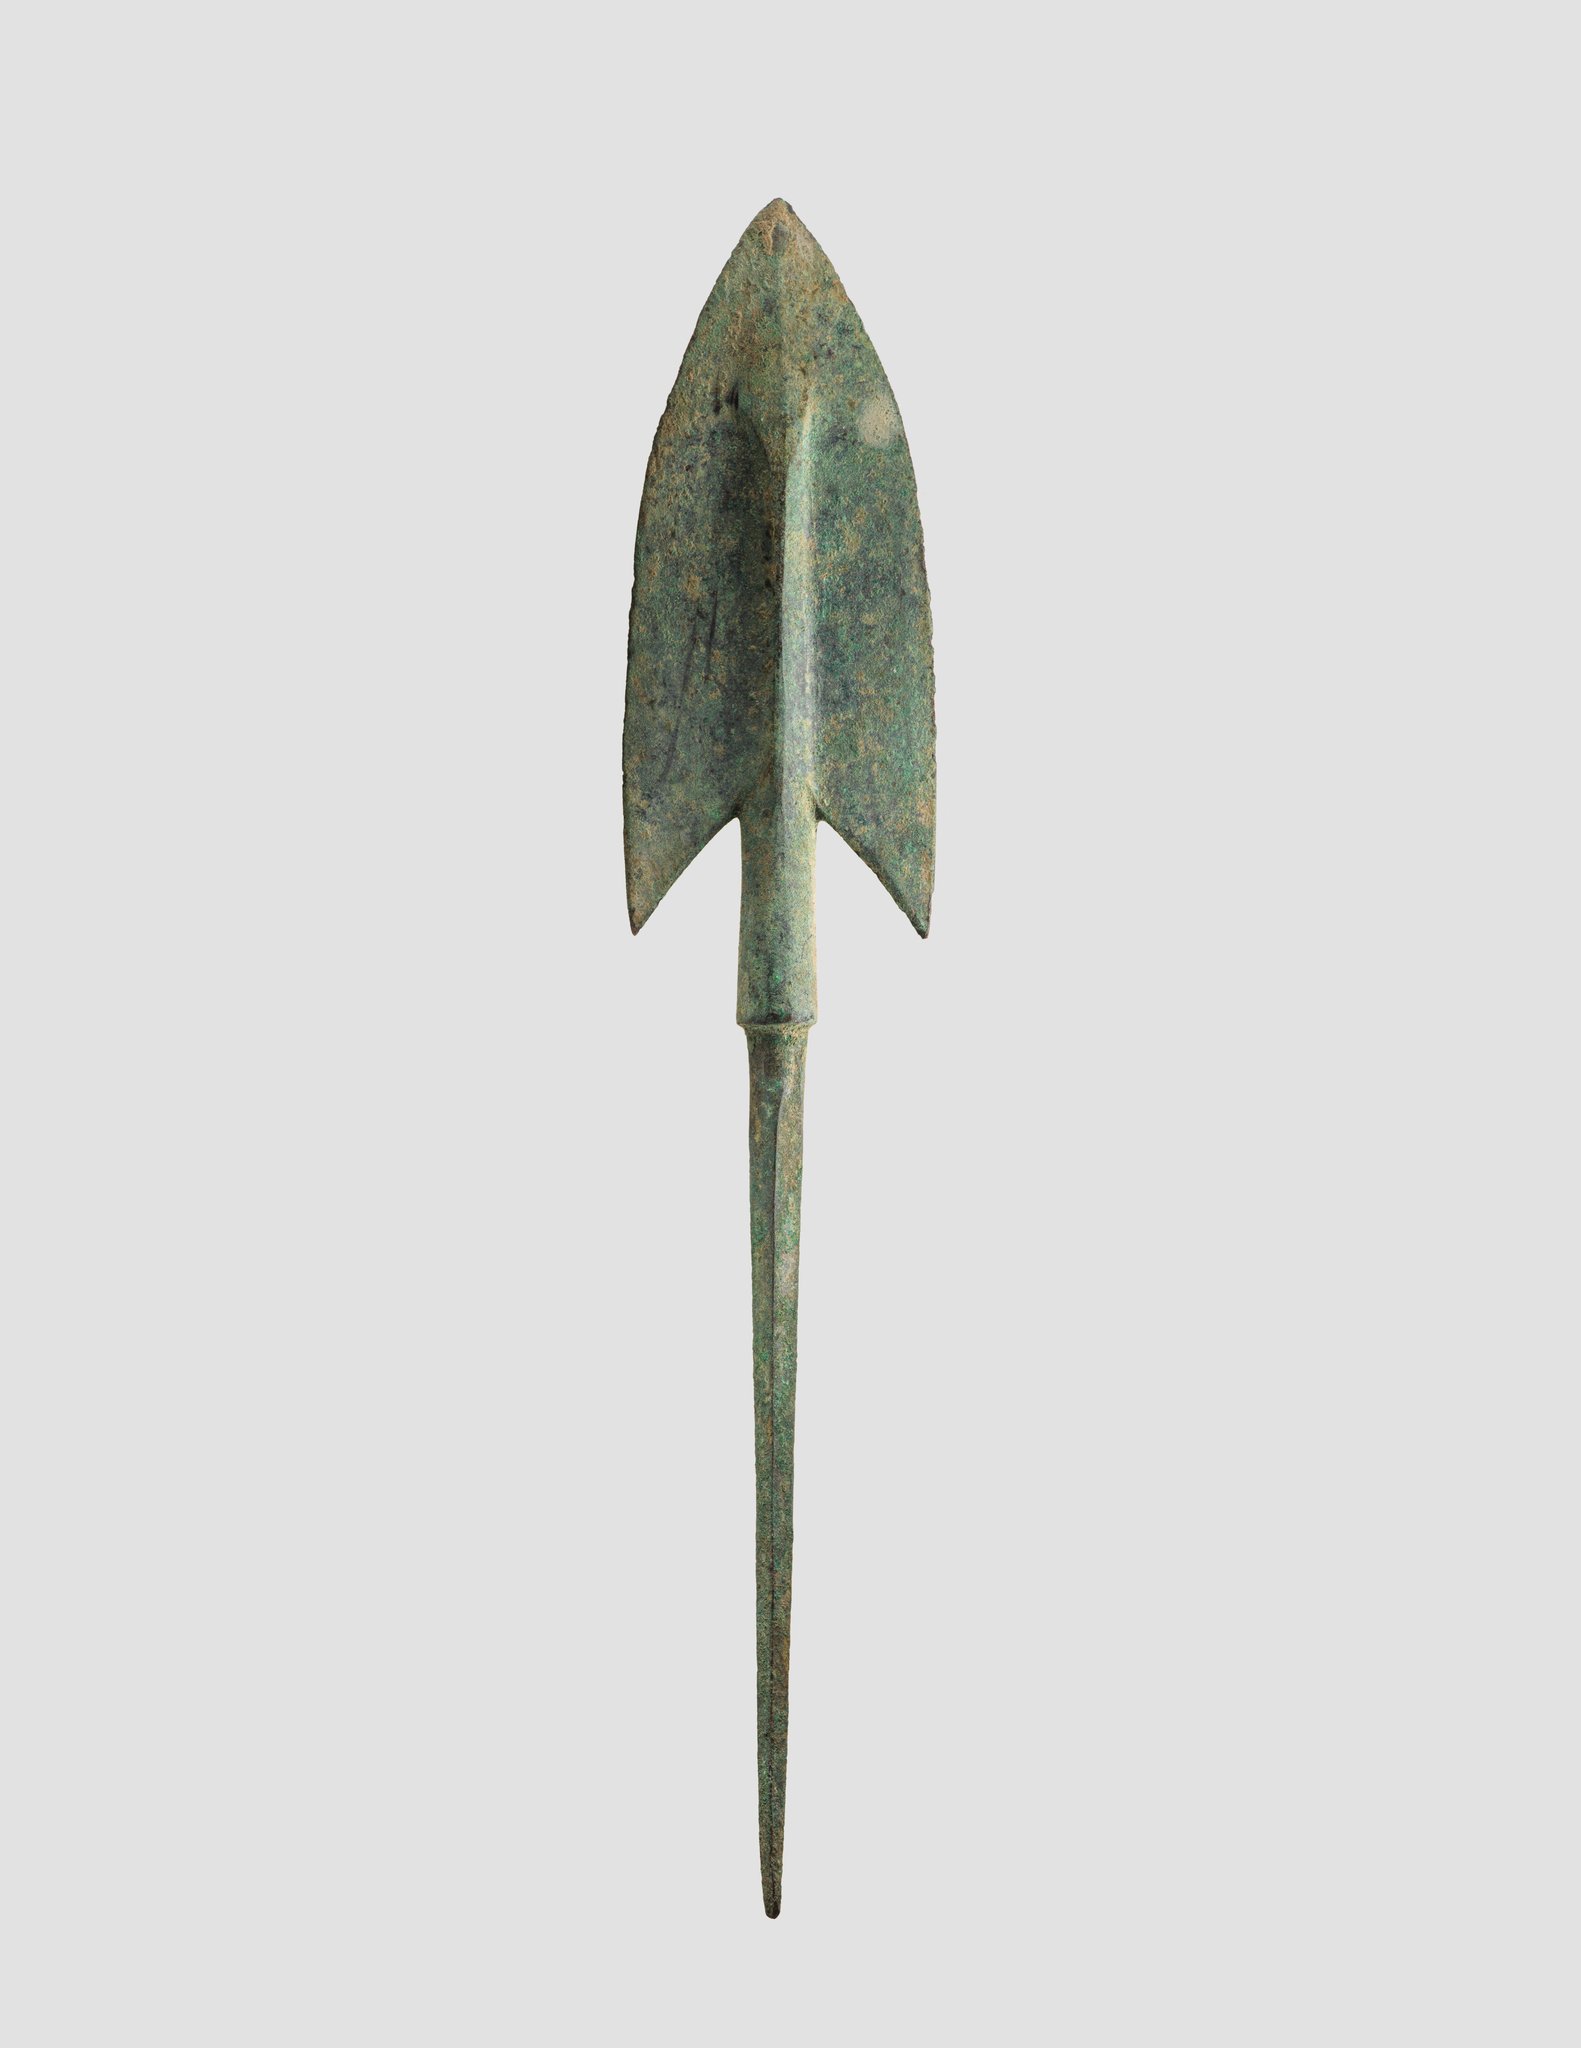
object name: arrowhead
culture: iranian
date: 2000-1 BCE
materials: bronze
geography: iran